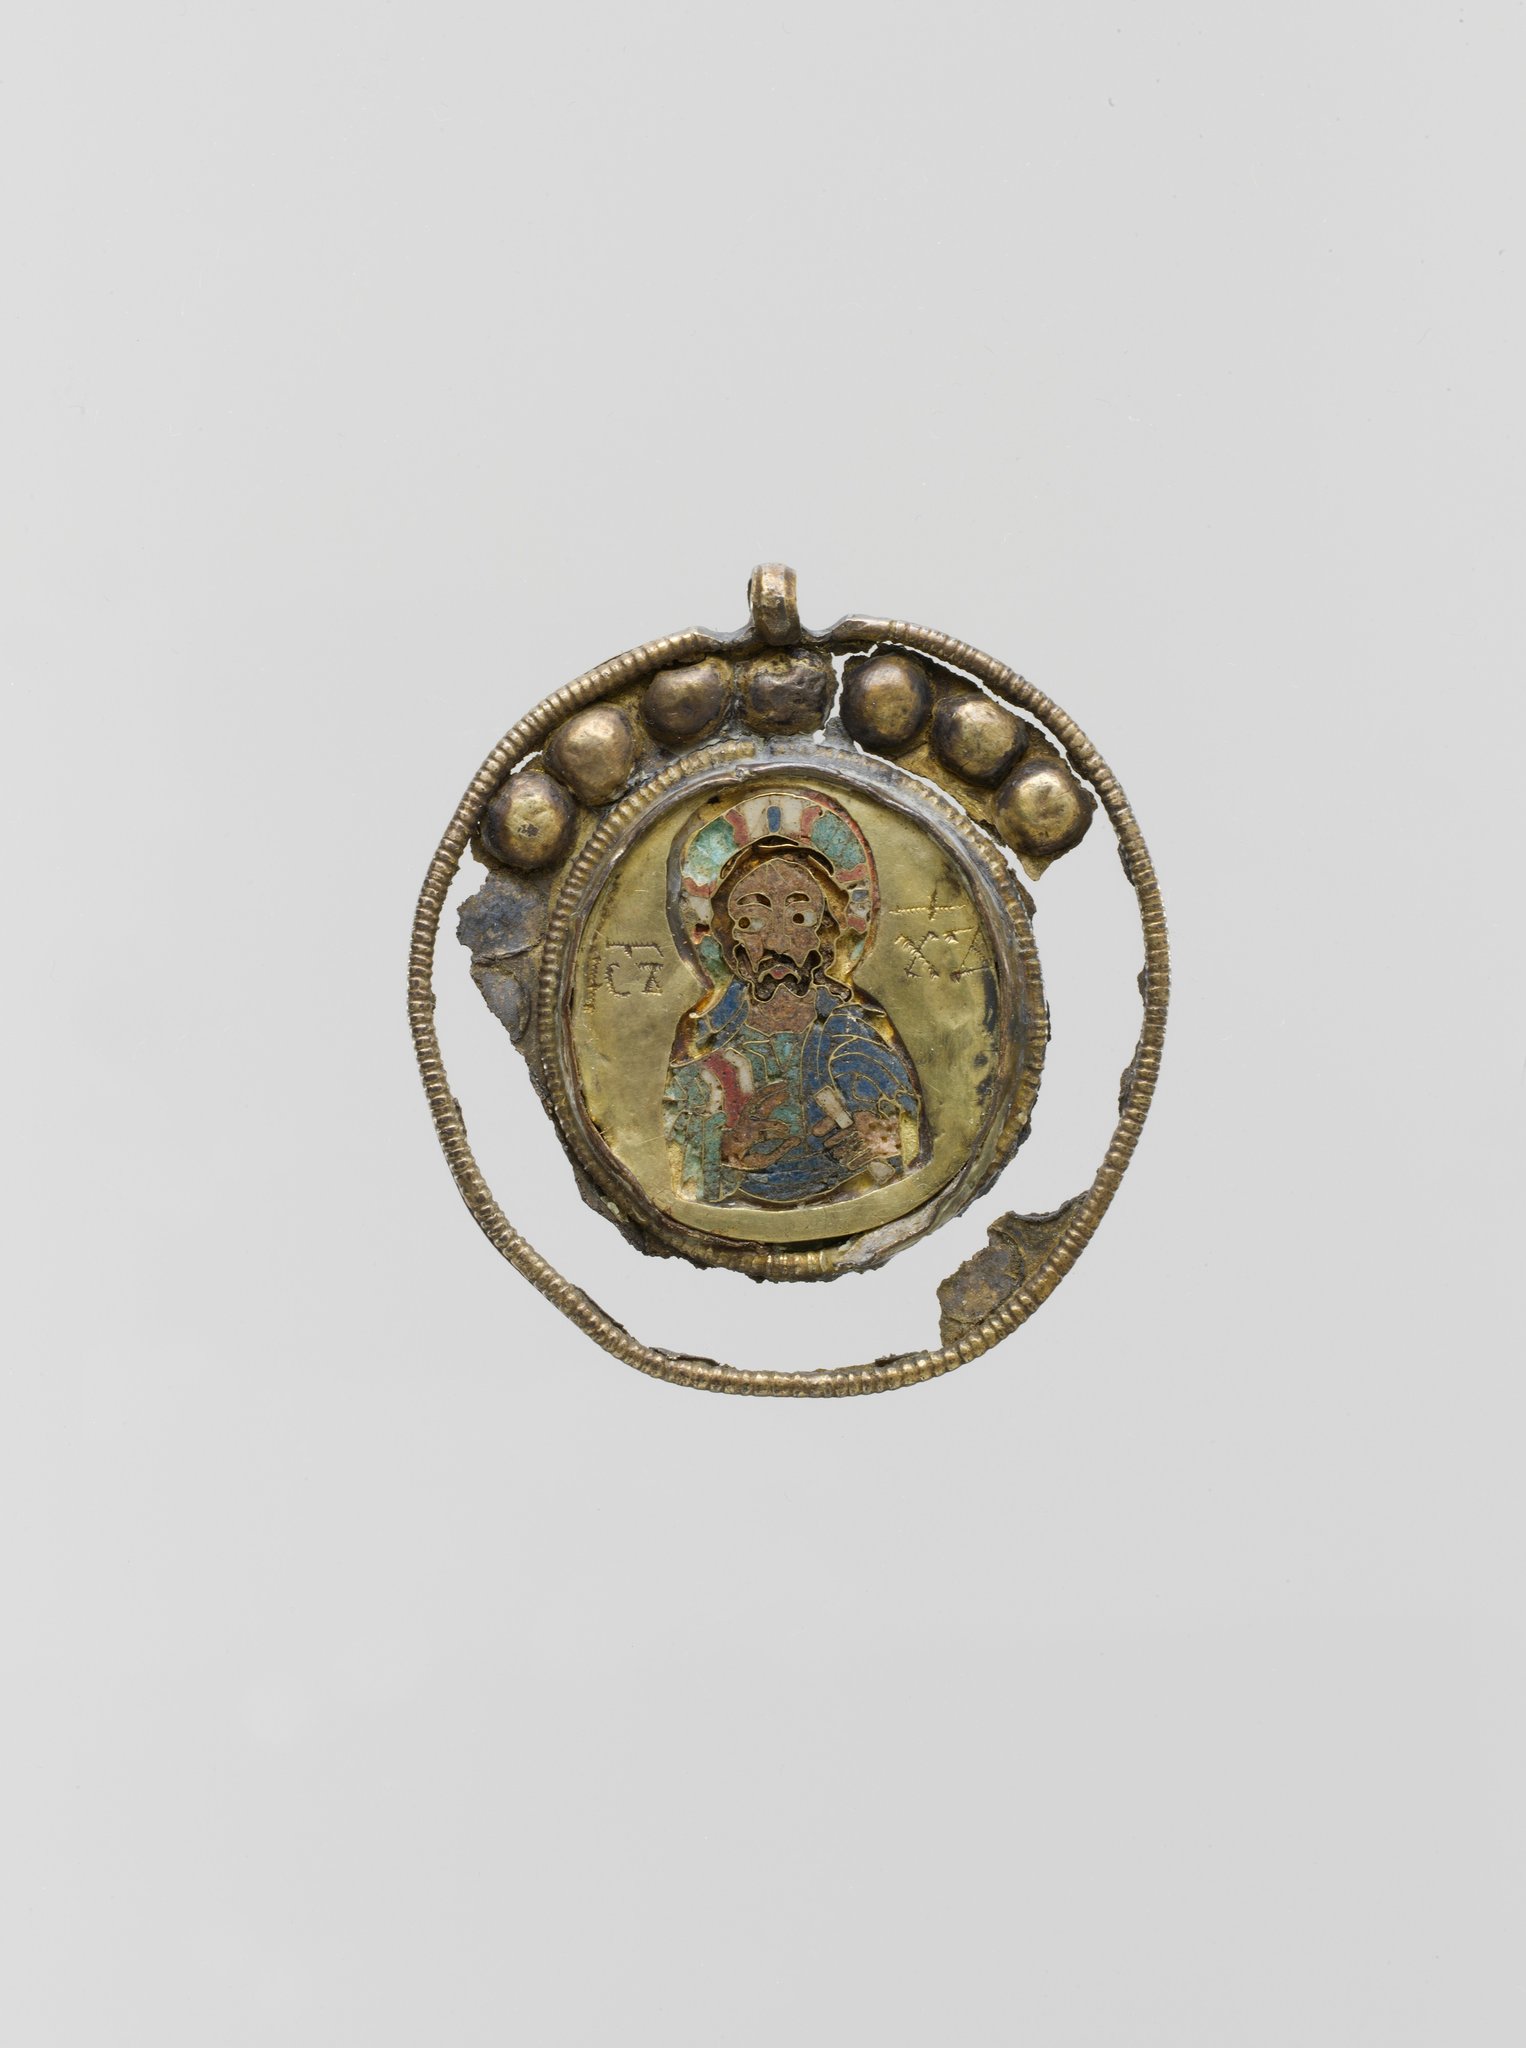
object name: medallion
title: Medallion from pendant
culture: ukrainian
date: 1101-1200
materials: enamel, gold, silver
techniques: enamel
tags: men,portraits